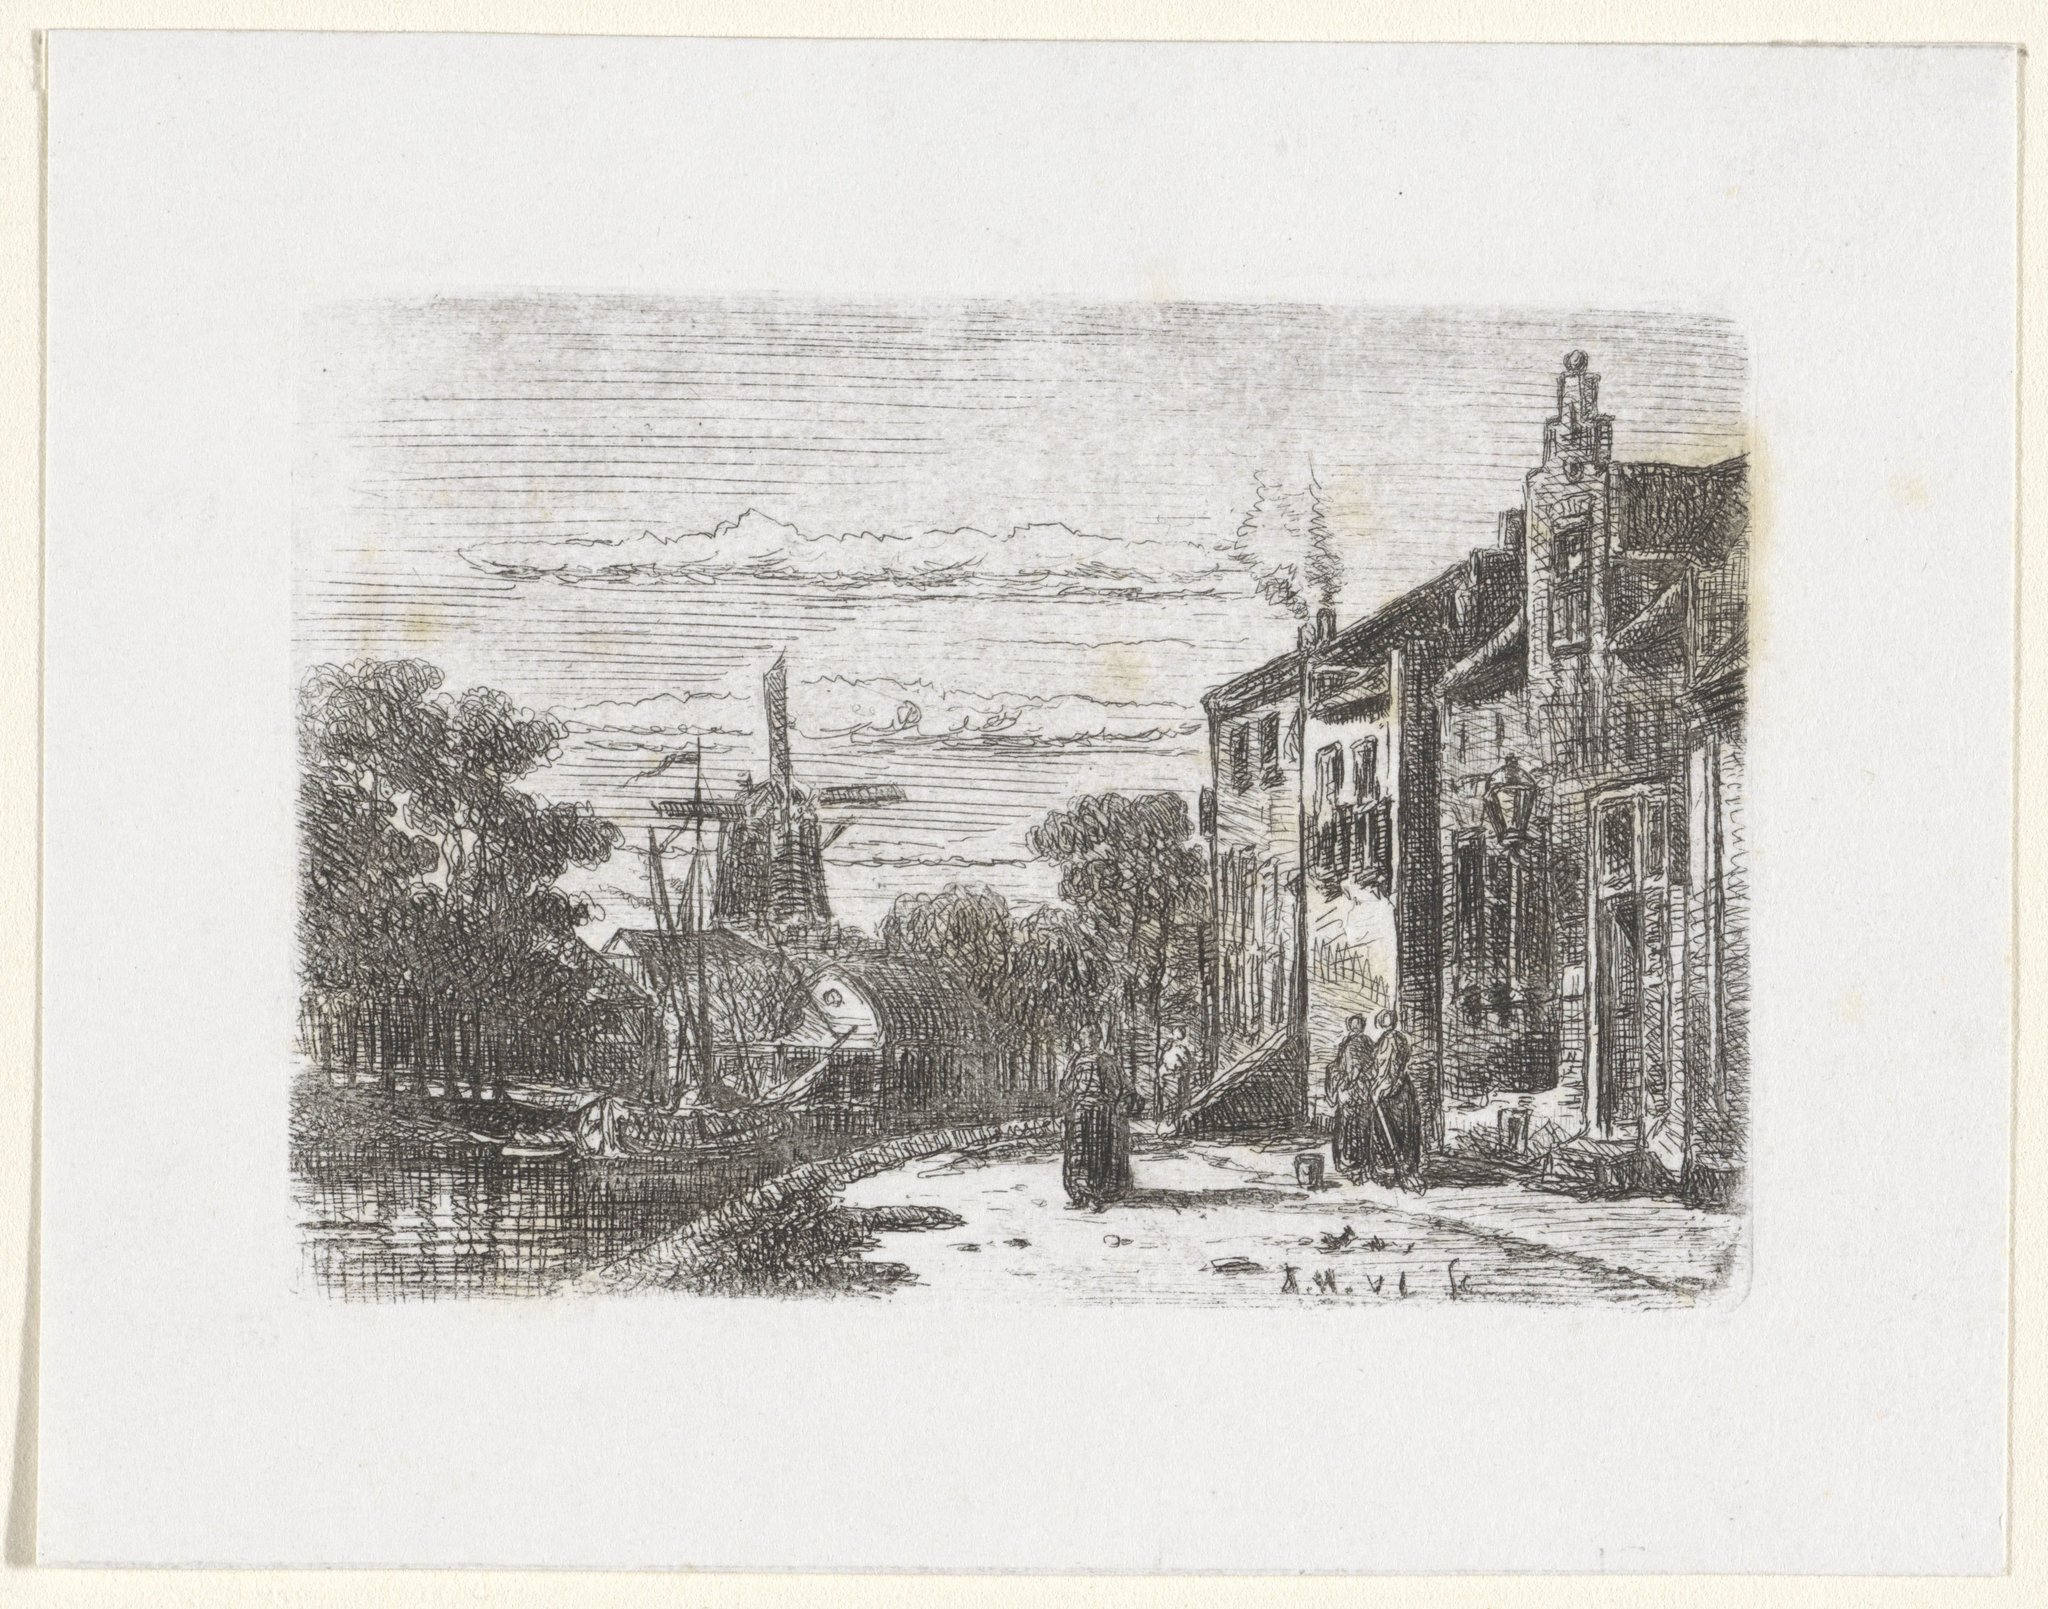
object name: print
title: Gezicht op een kanaal bij een molen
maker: frederik hendrik weissenbruch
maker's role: draughtsman, print maker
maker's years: 1828-1887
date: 1843-1887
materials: paper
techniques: etching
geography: the hague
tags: adult woman, canal, ships (in general), housing, windmill in landscape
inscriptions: collector's mark: Lugt 1485, collector's mark: Lugt 2228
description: Op de kade langs een kanaal staan enkele vrouwen. Rechts zijn huizen te zien. In de verte ligt een boot in het water en is het silhouet van een molen weergegeven.